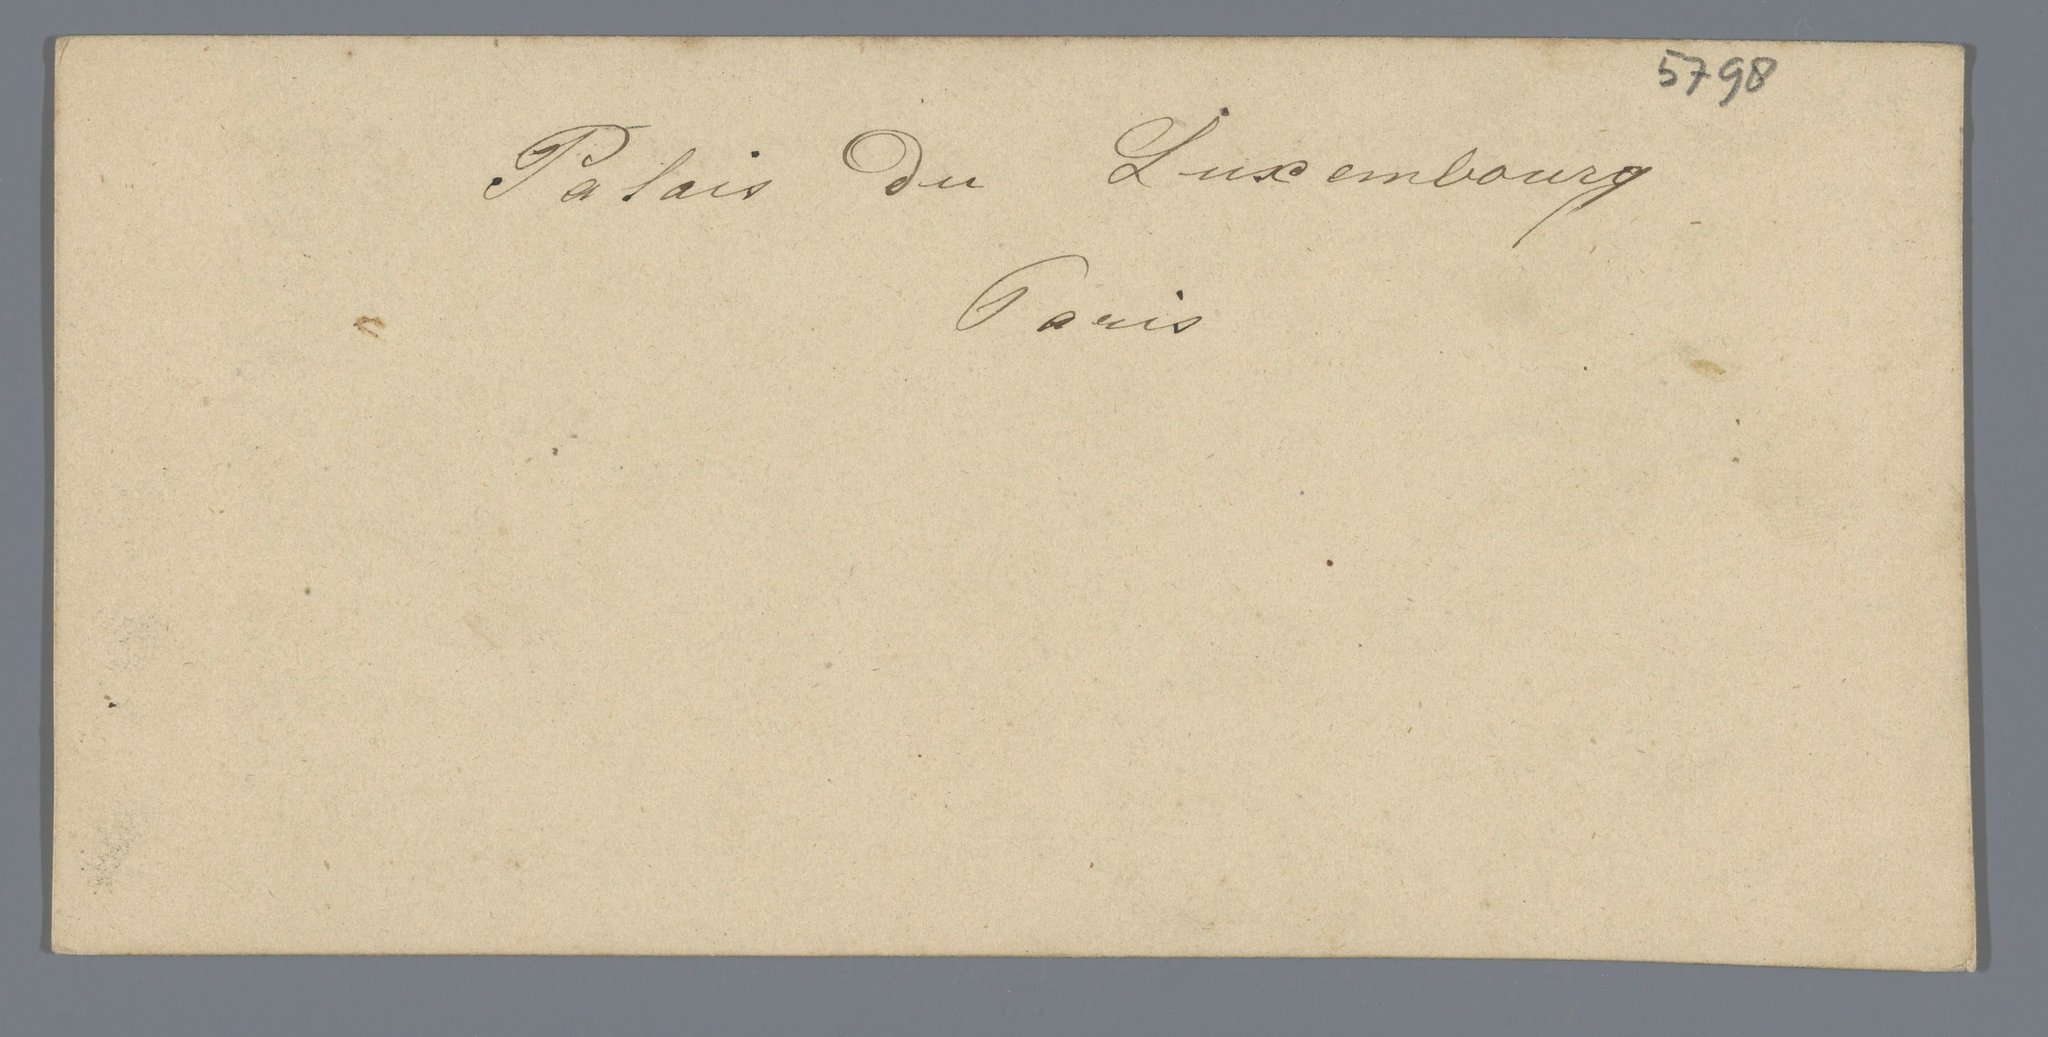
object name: stereograph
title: Gezicht op het Palais du Luxembourg in Parijs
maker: Anonymous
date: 1855-1860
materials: cardboard, photographic support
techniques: albumen print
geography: paris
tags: palace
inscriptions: inscription: ‘Palais du Luxembourg Paris’